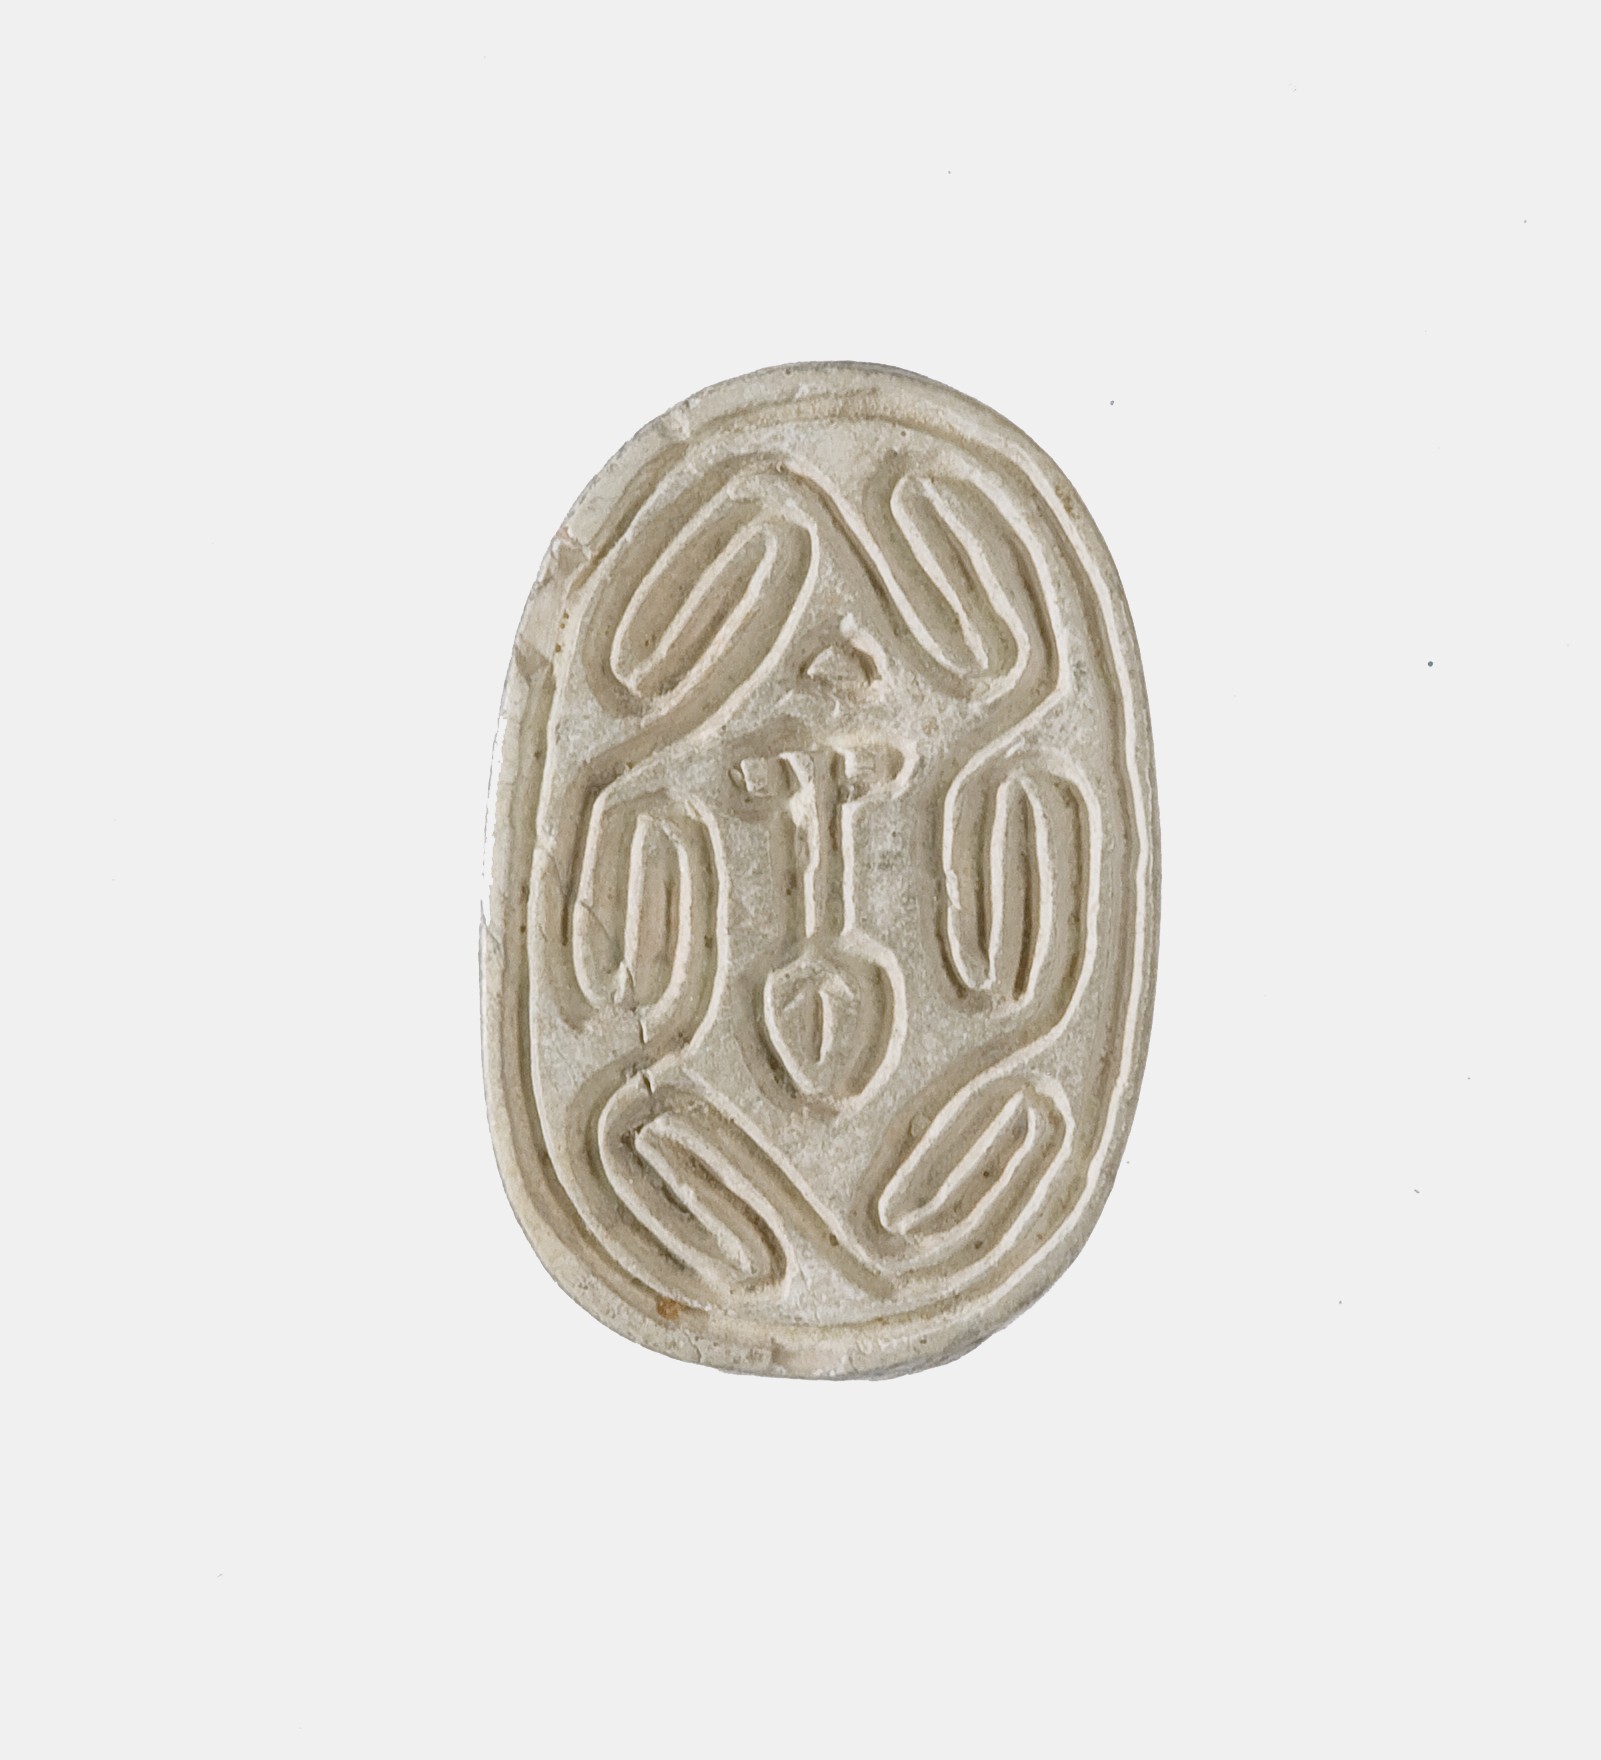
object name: scarab, nefer, scroll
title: Scarab Incised with Hieroglyphs in Scroll Border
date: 1850-1640 BCE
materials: stone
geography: egypt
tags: scarabs